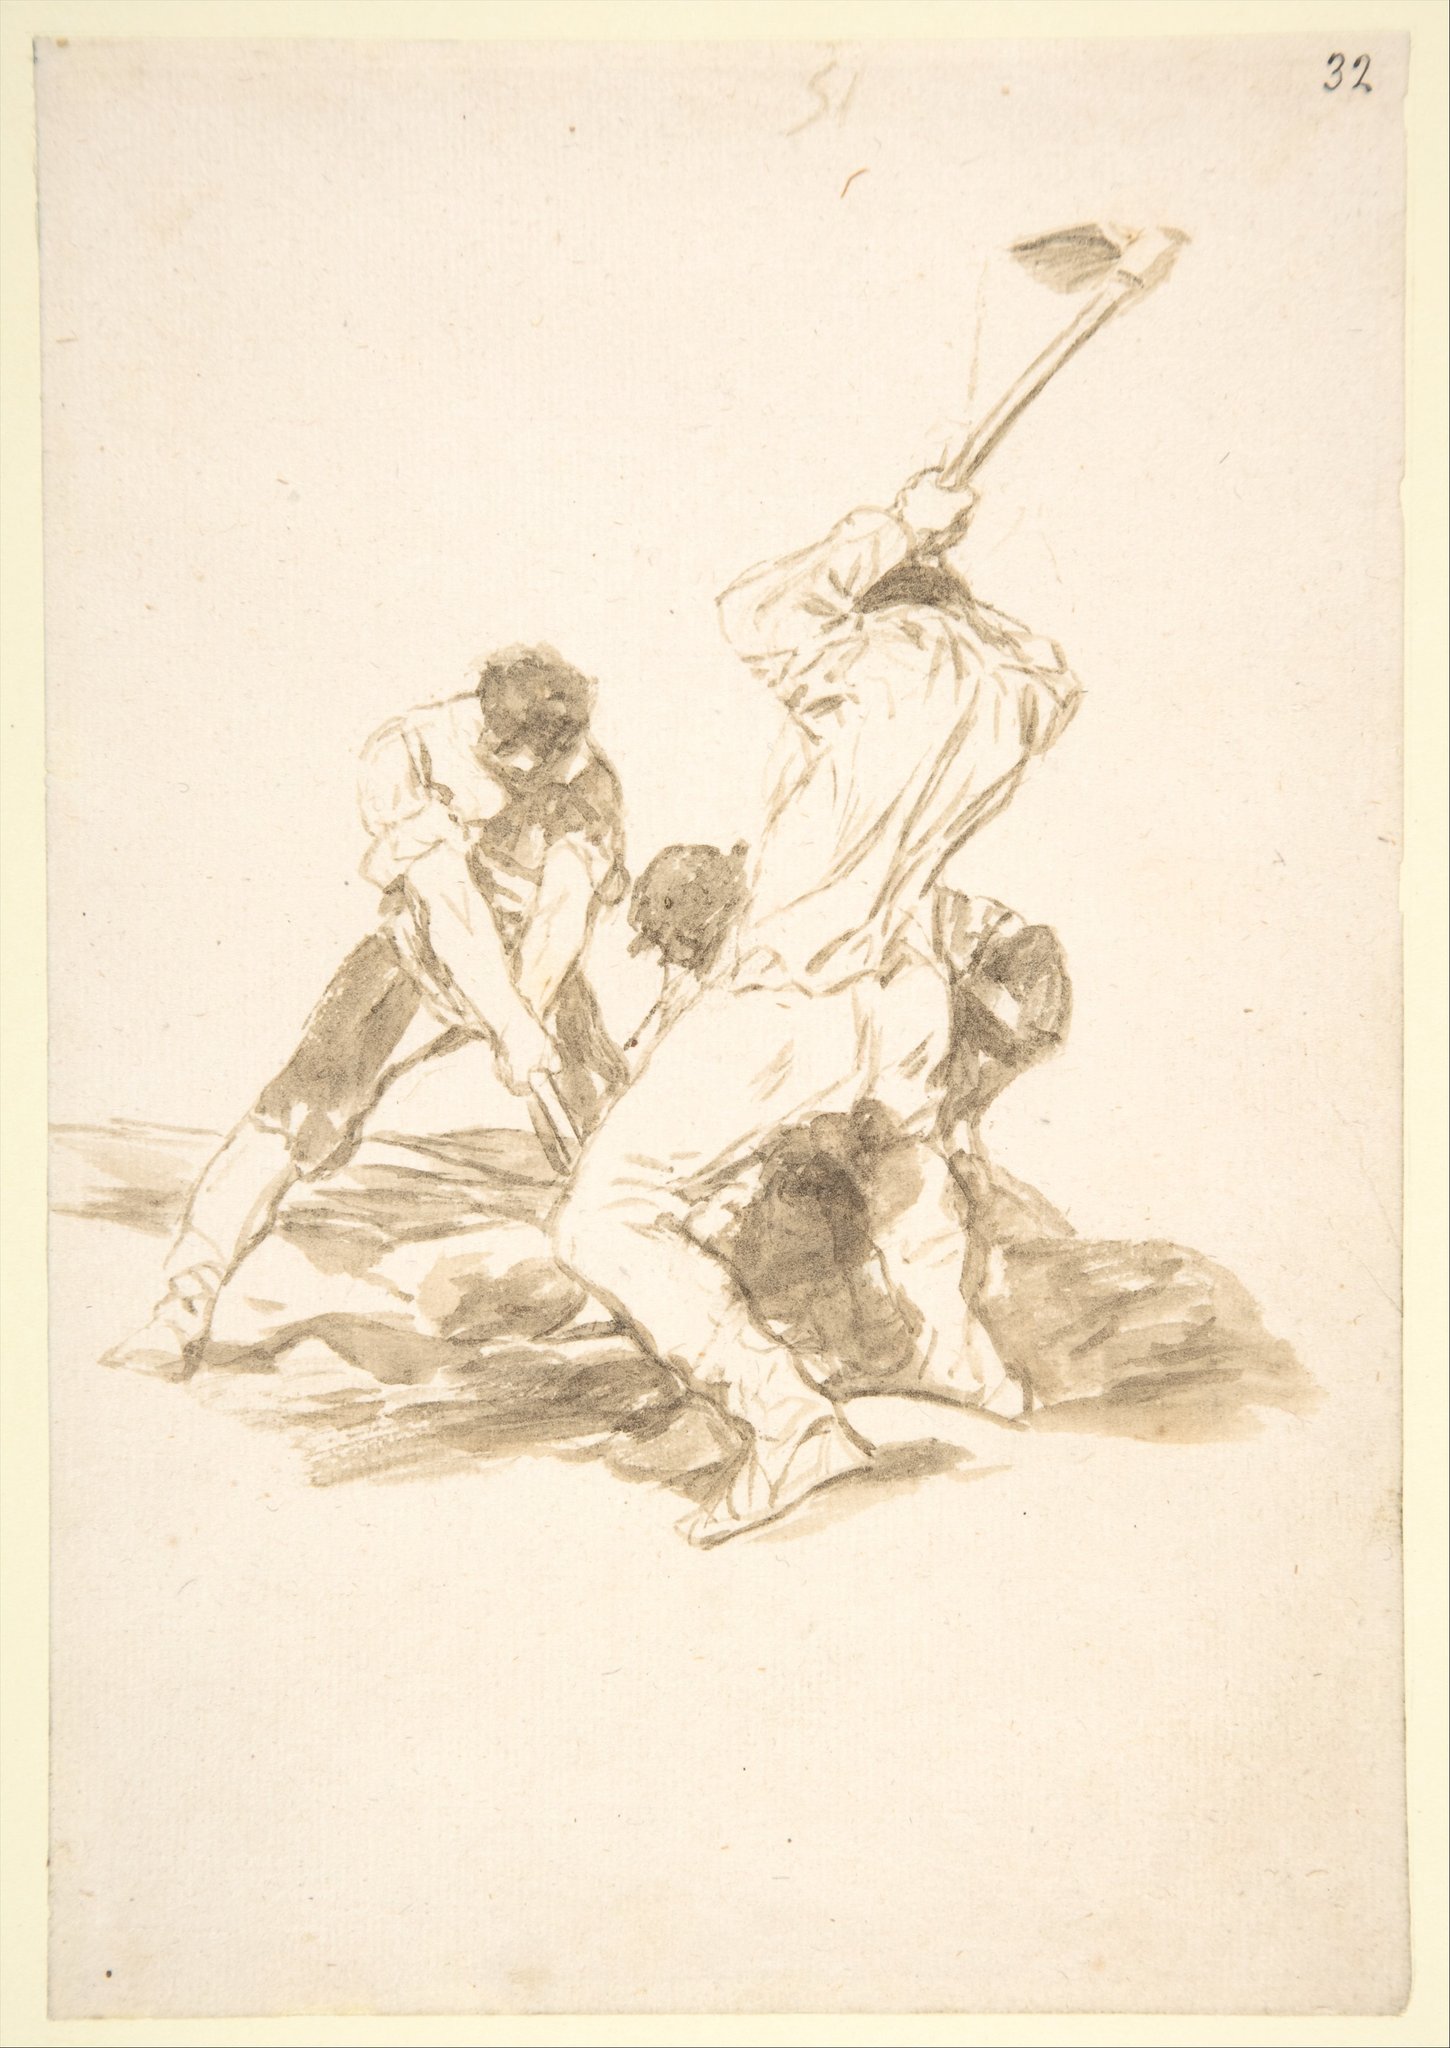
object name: drawing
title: Three men digging; folio 51 from the "Images of Spain" Album (F)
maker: goya (francisco de goya y lucientes)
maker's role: artist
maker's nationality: spanish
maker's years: 1746-1828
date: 1812-1820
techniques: brush, wash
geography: spain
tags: men,working